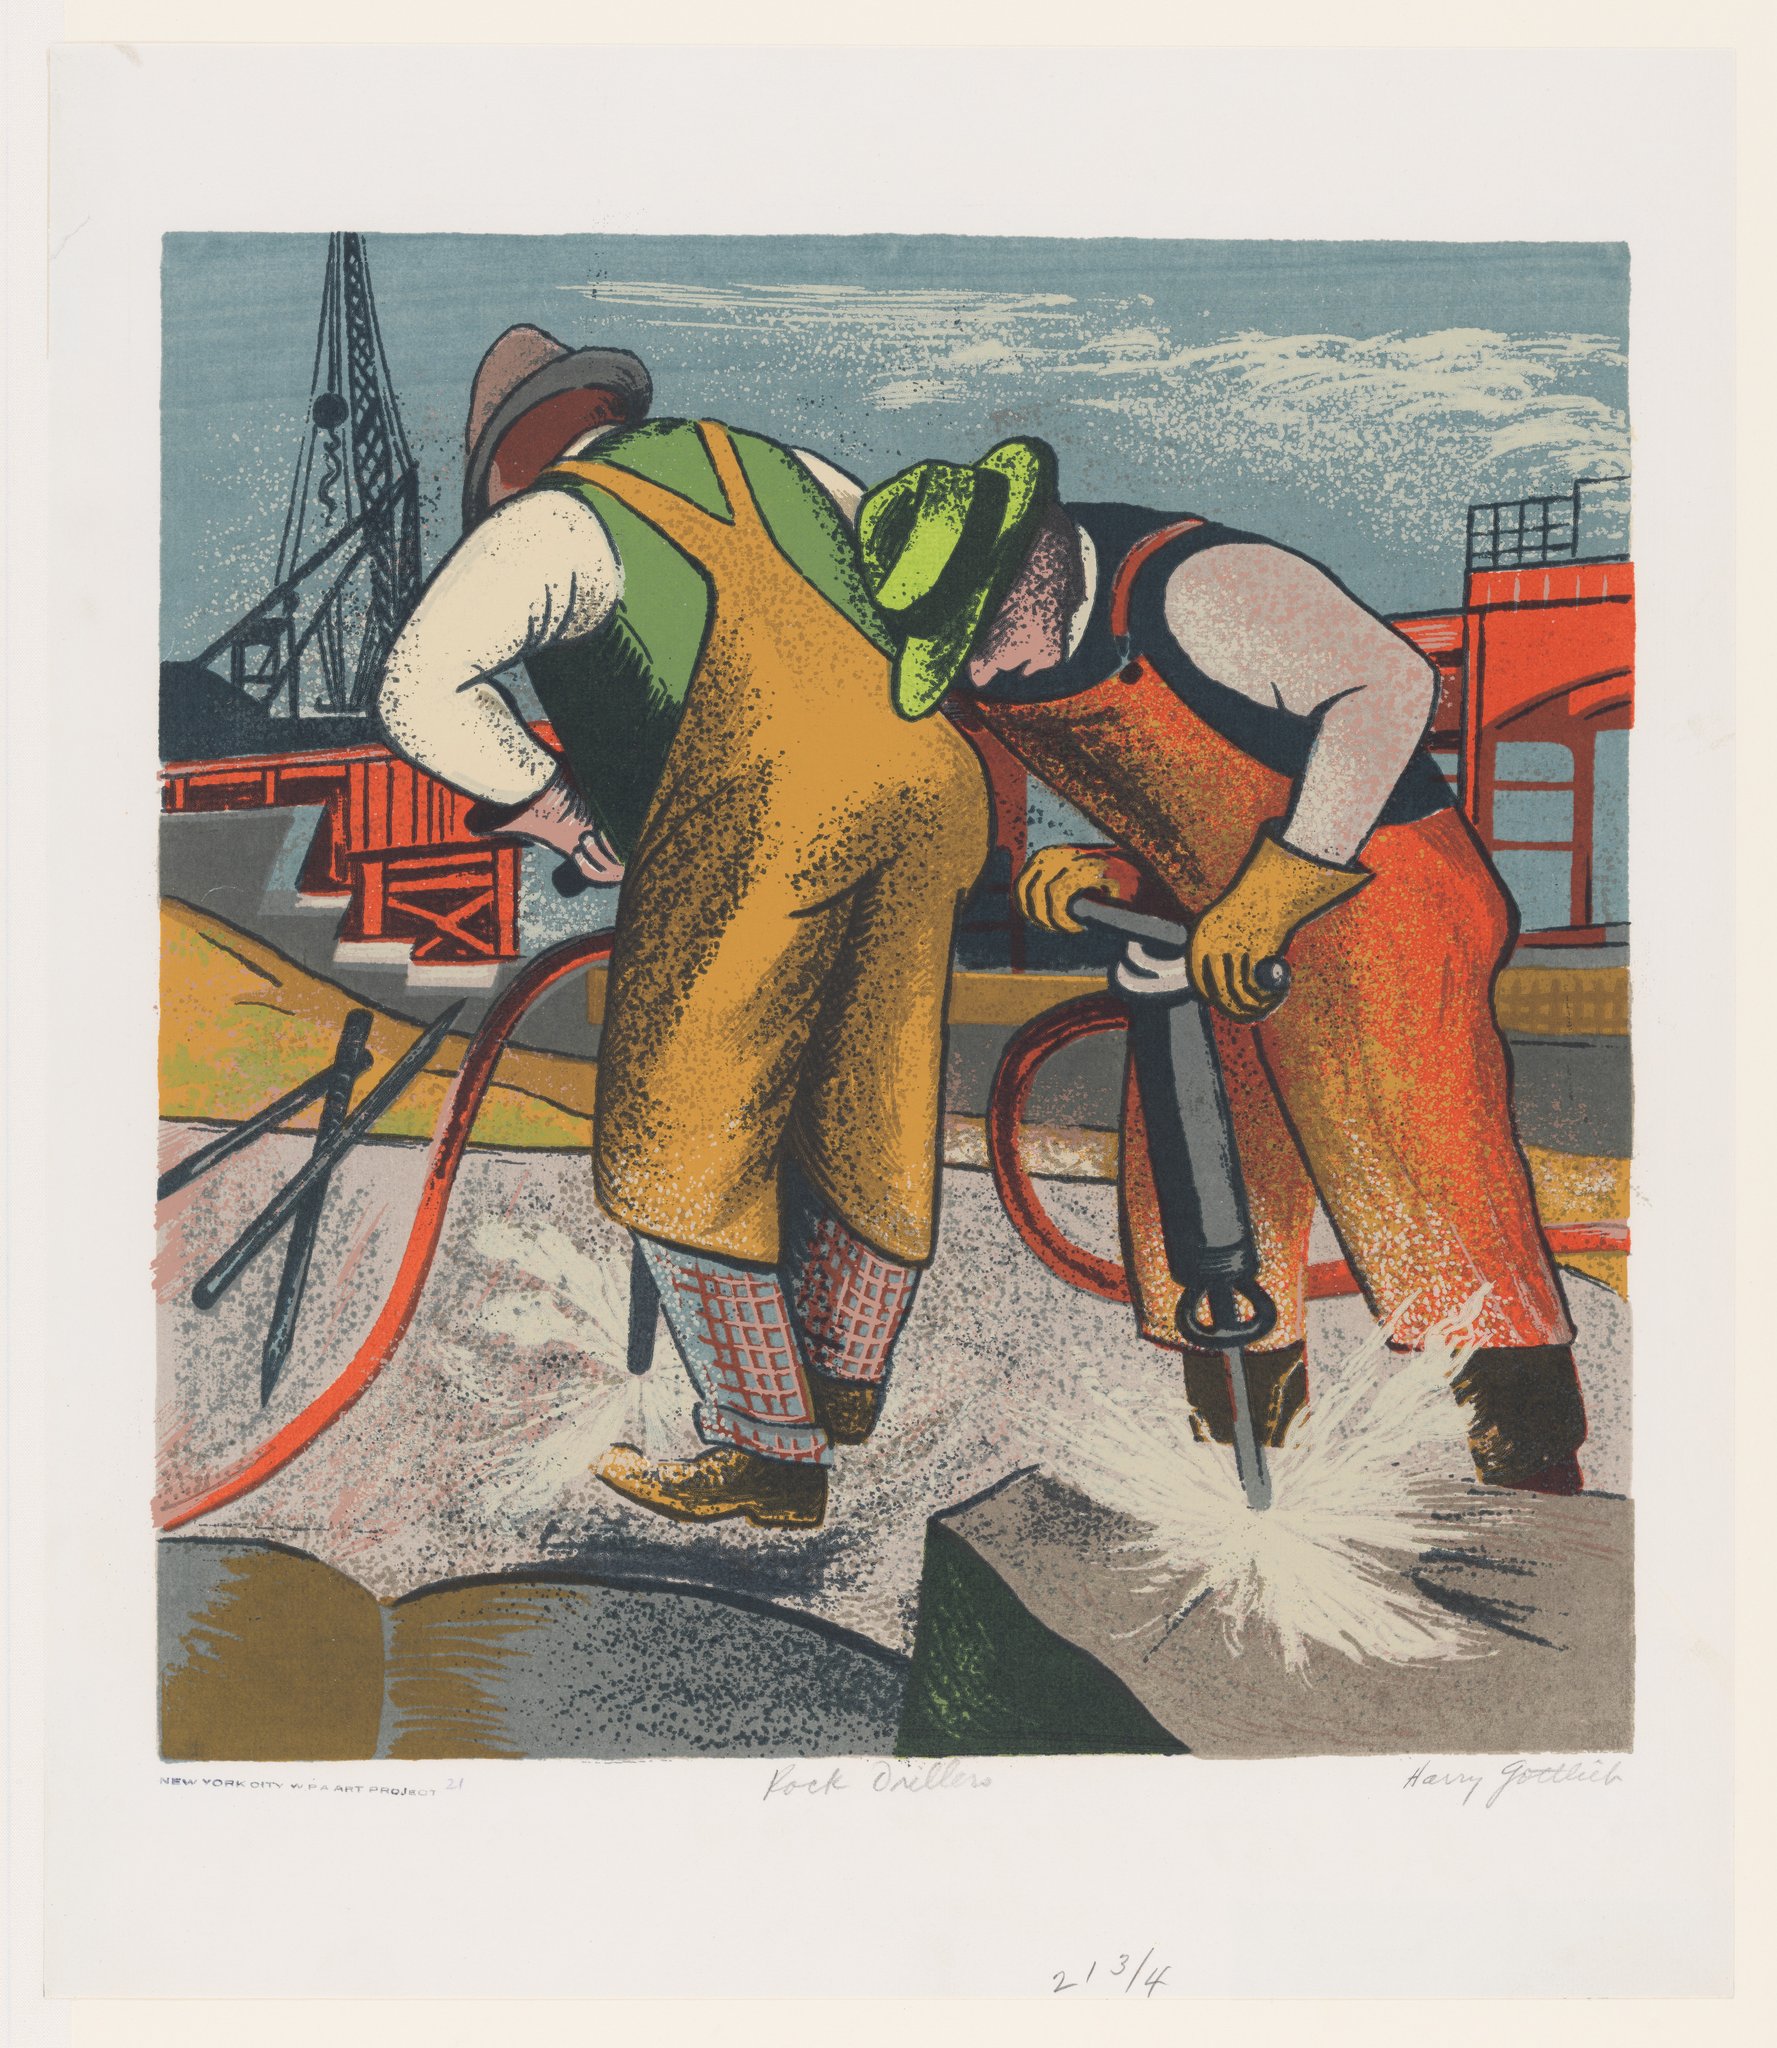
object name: print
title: Rock Drillers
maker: harry gottlieb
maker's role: artist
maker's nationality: american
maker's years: 1894-1992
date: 1939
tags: men,working